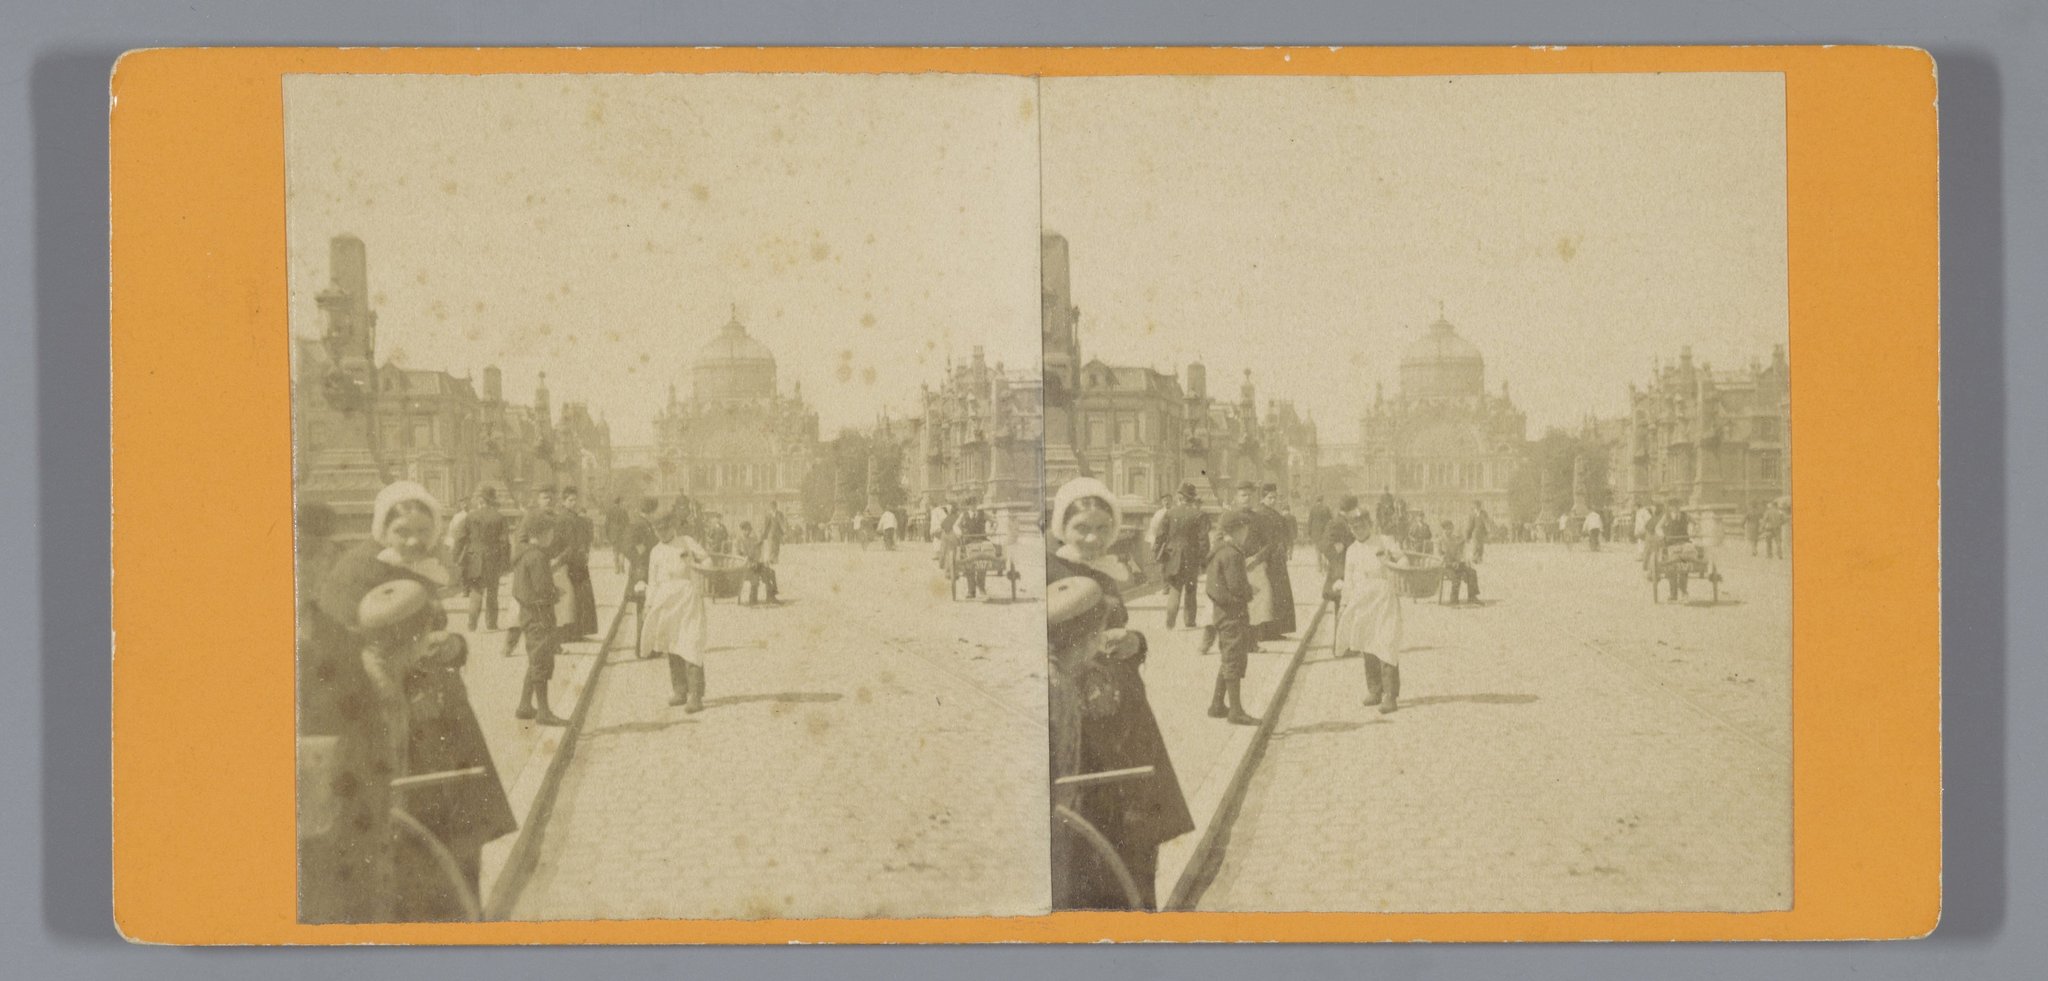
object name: stereograph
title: Paleis voor Volksvlijt vanaf de Hogesluis, Amsterdam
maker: Anonymous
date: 1883-1900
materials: cardboard, paper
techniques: albumen print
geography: amsterdam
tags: bridge in city across river, canal, etc., edifice, e.g.: public building, department store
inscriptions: inscription: ‘25 Amsterdam/ Paleis voor Volksvlijt’